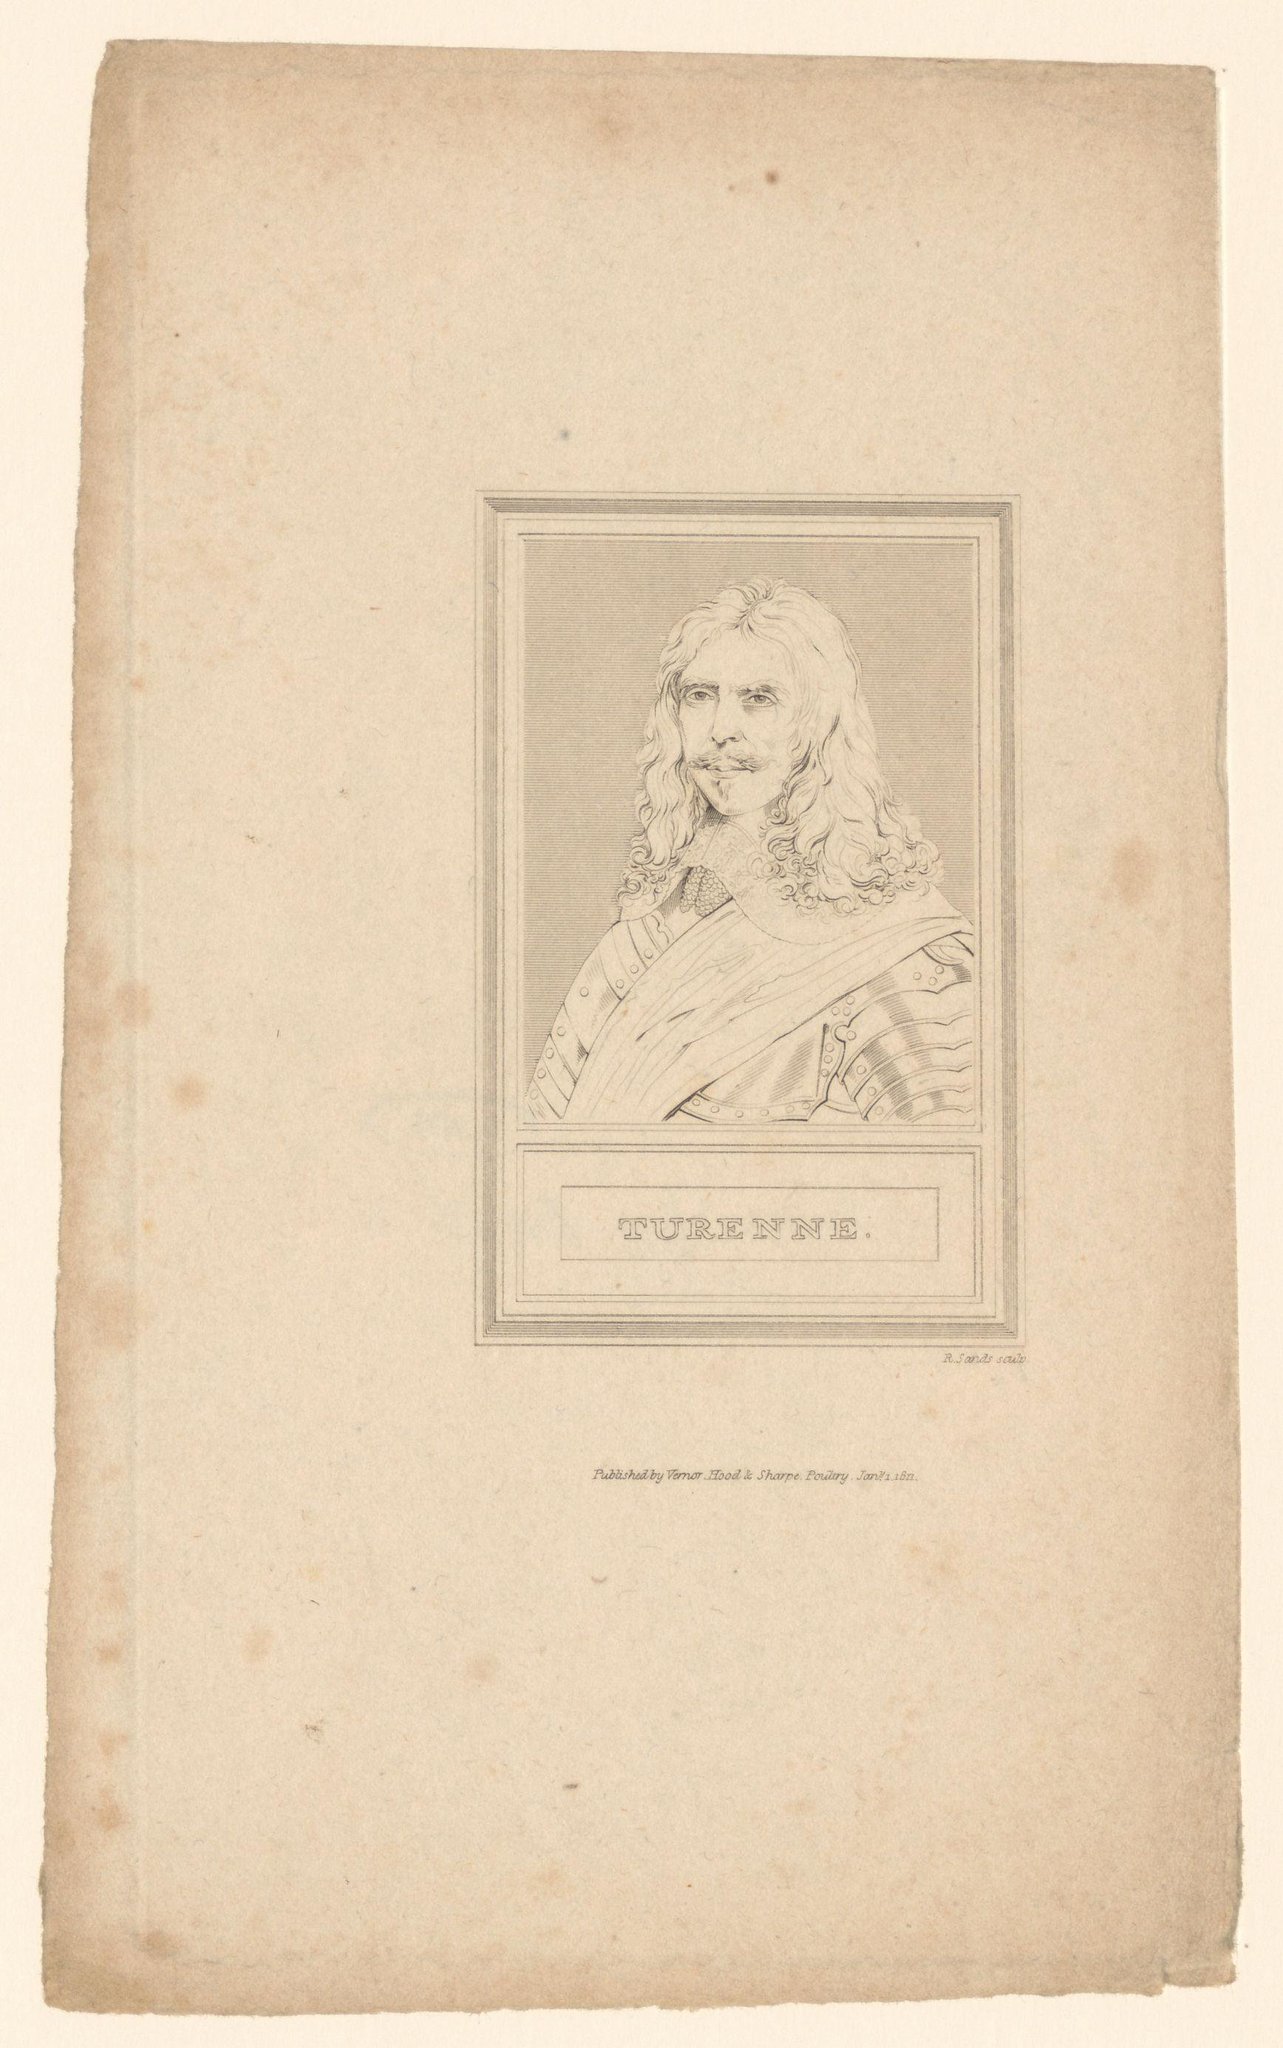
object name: print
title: Portret van Henri de La Tour d’Auvergne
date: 1811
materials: paper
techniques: engraving, etching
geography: london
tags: historical persons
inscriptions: collector's mark: Lugt 2228